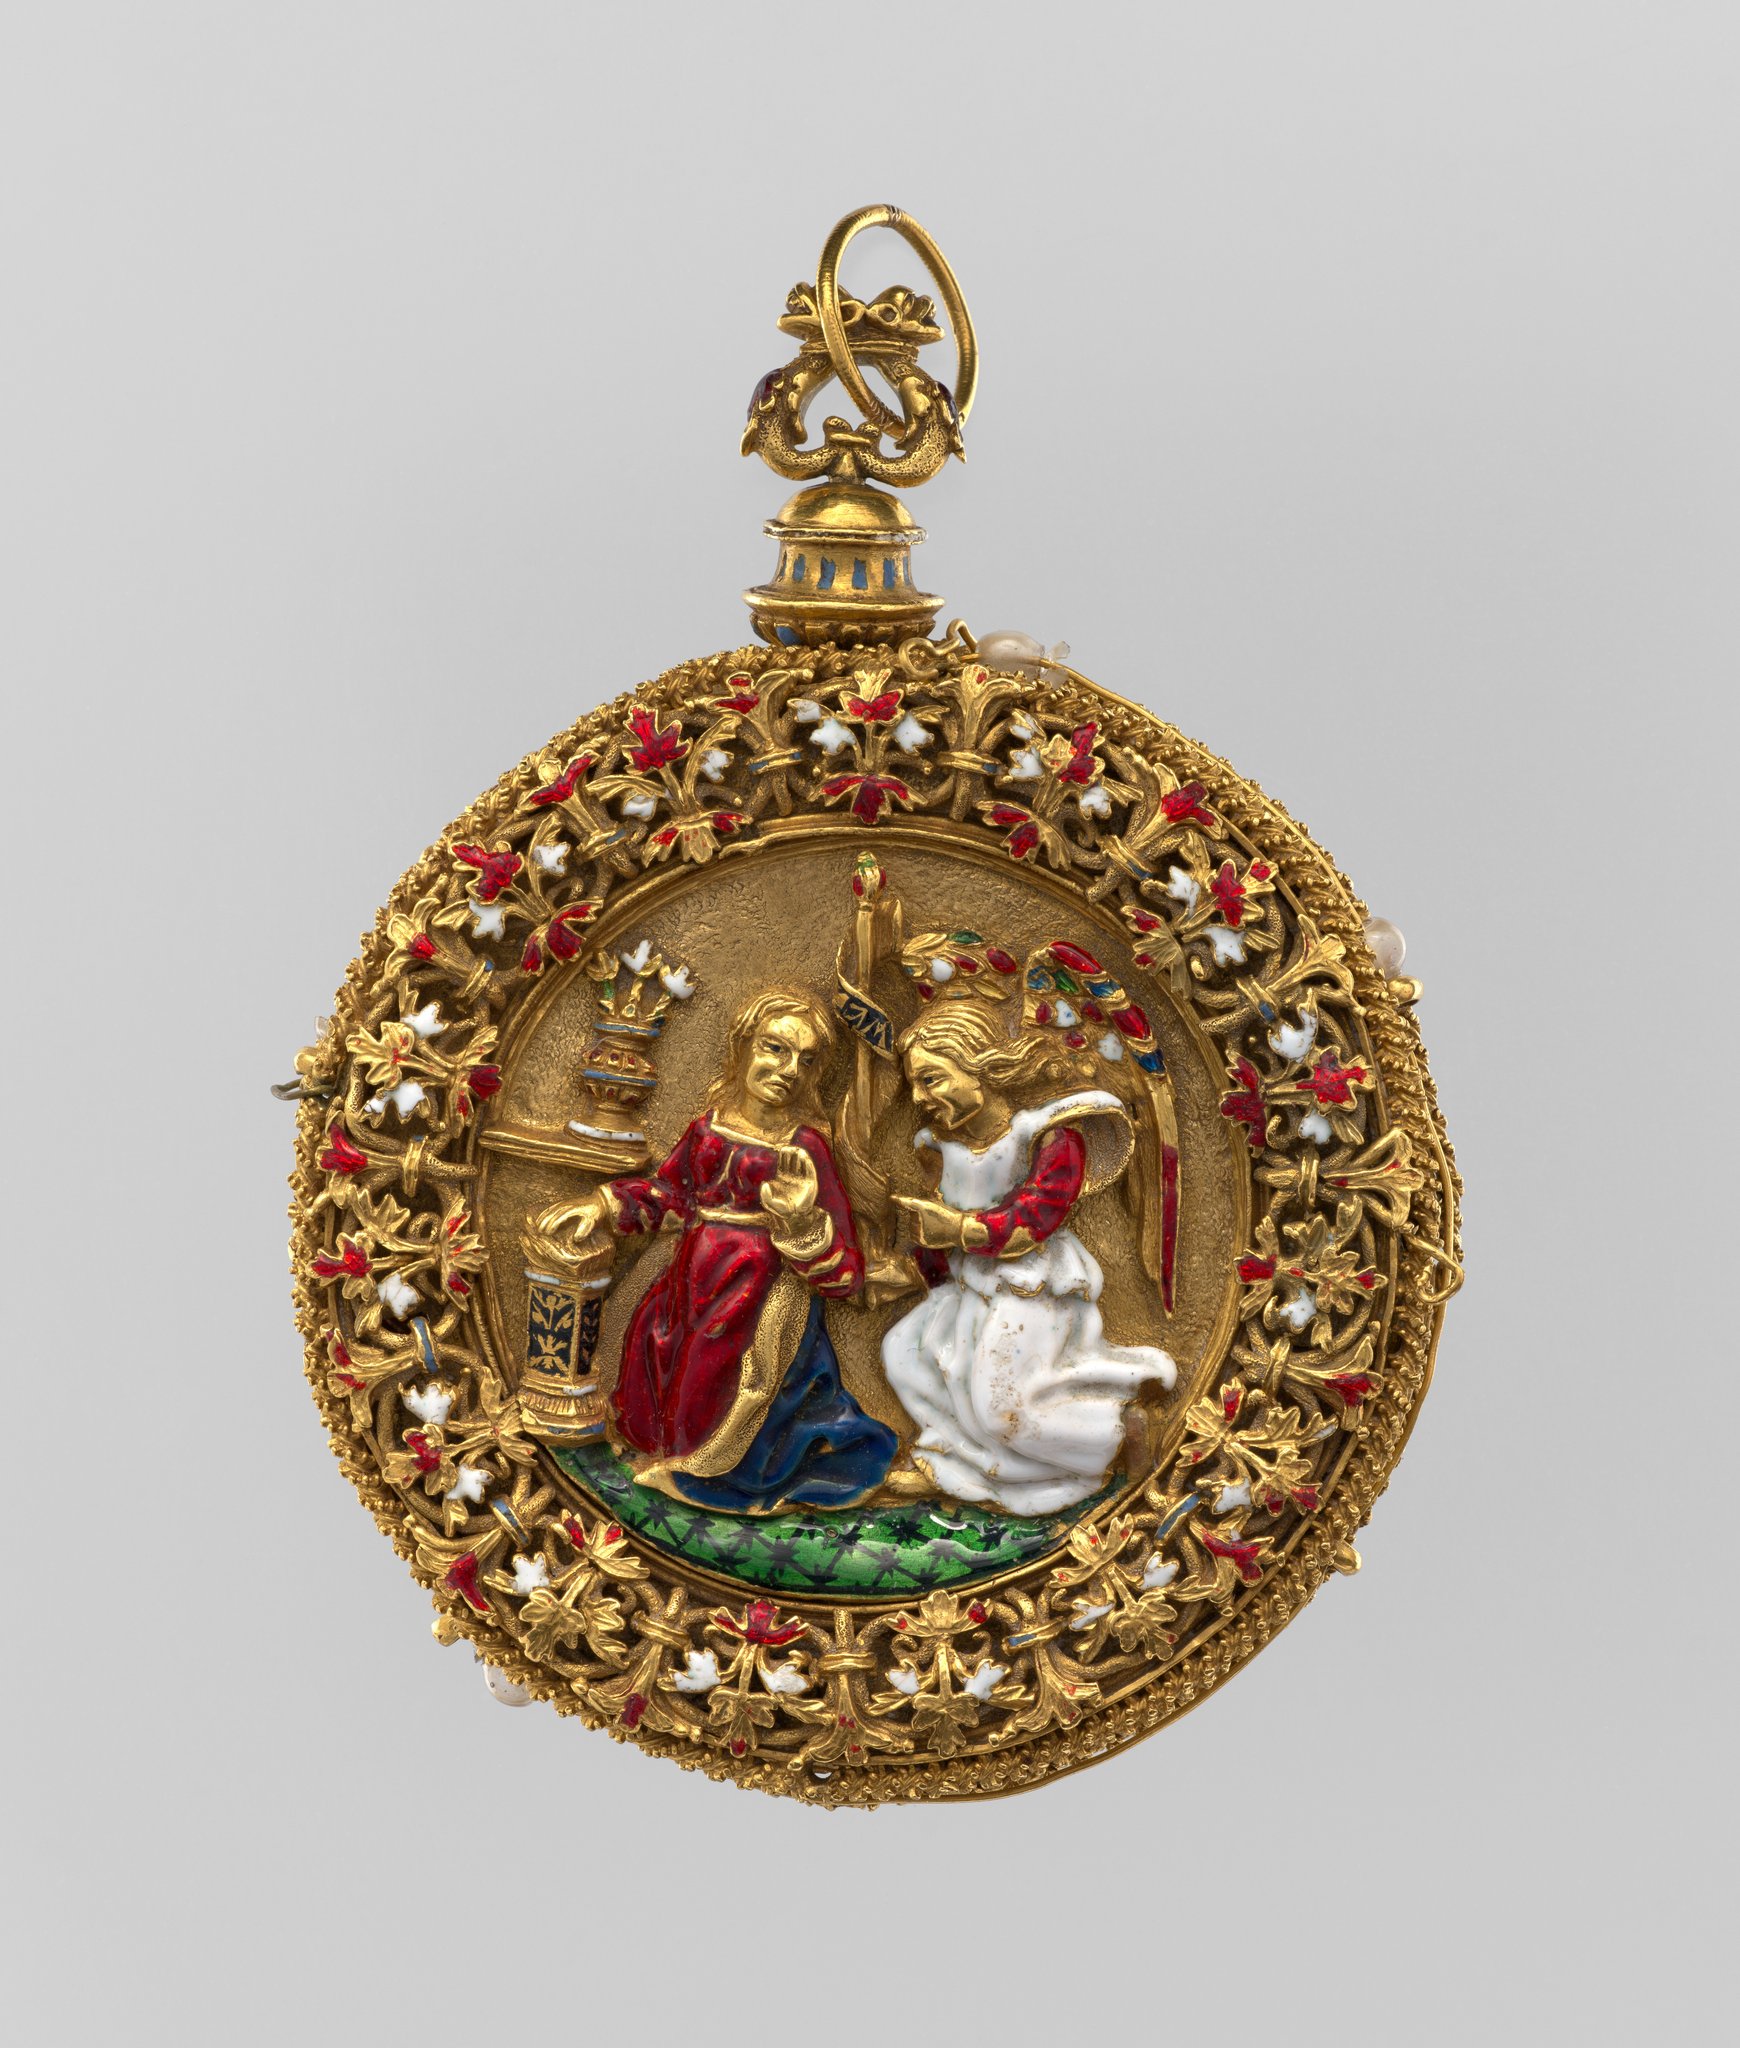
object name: pendant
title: Pendant with scene of the Annunciation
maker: salomon weininger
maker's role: maker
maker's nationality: austrian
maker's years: 1822-1879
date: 1851-1875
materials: enamel, glass, gold, pearl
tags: virgin mary,annunciation